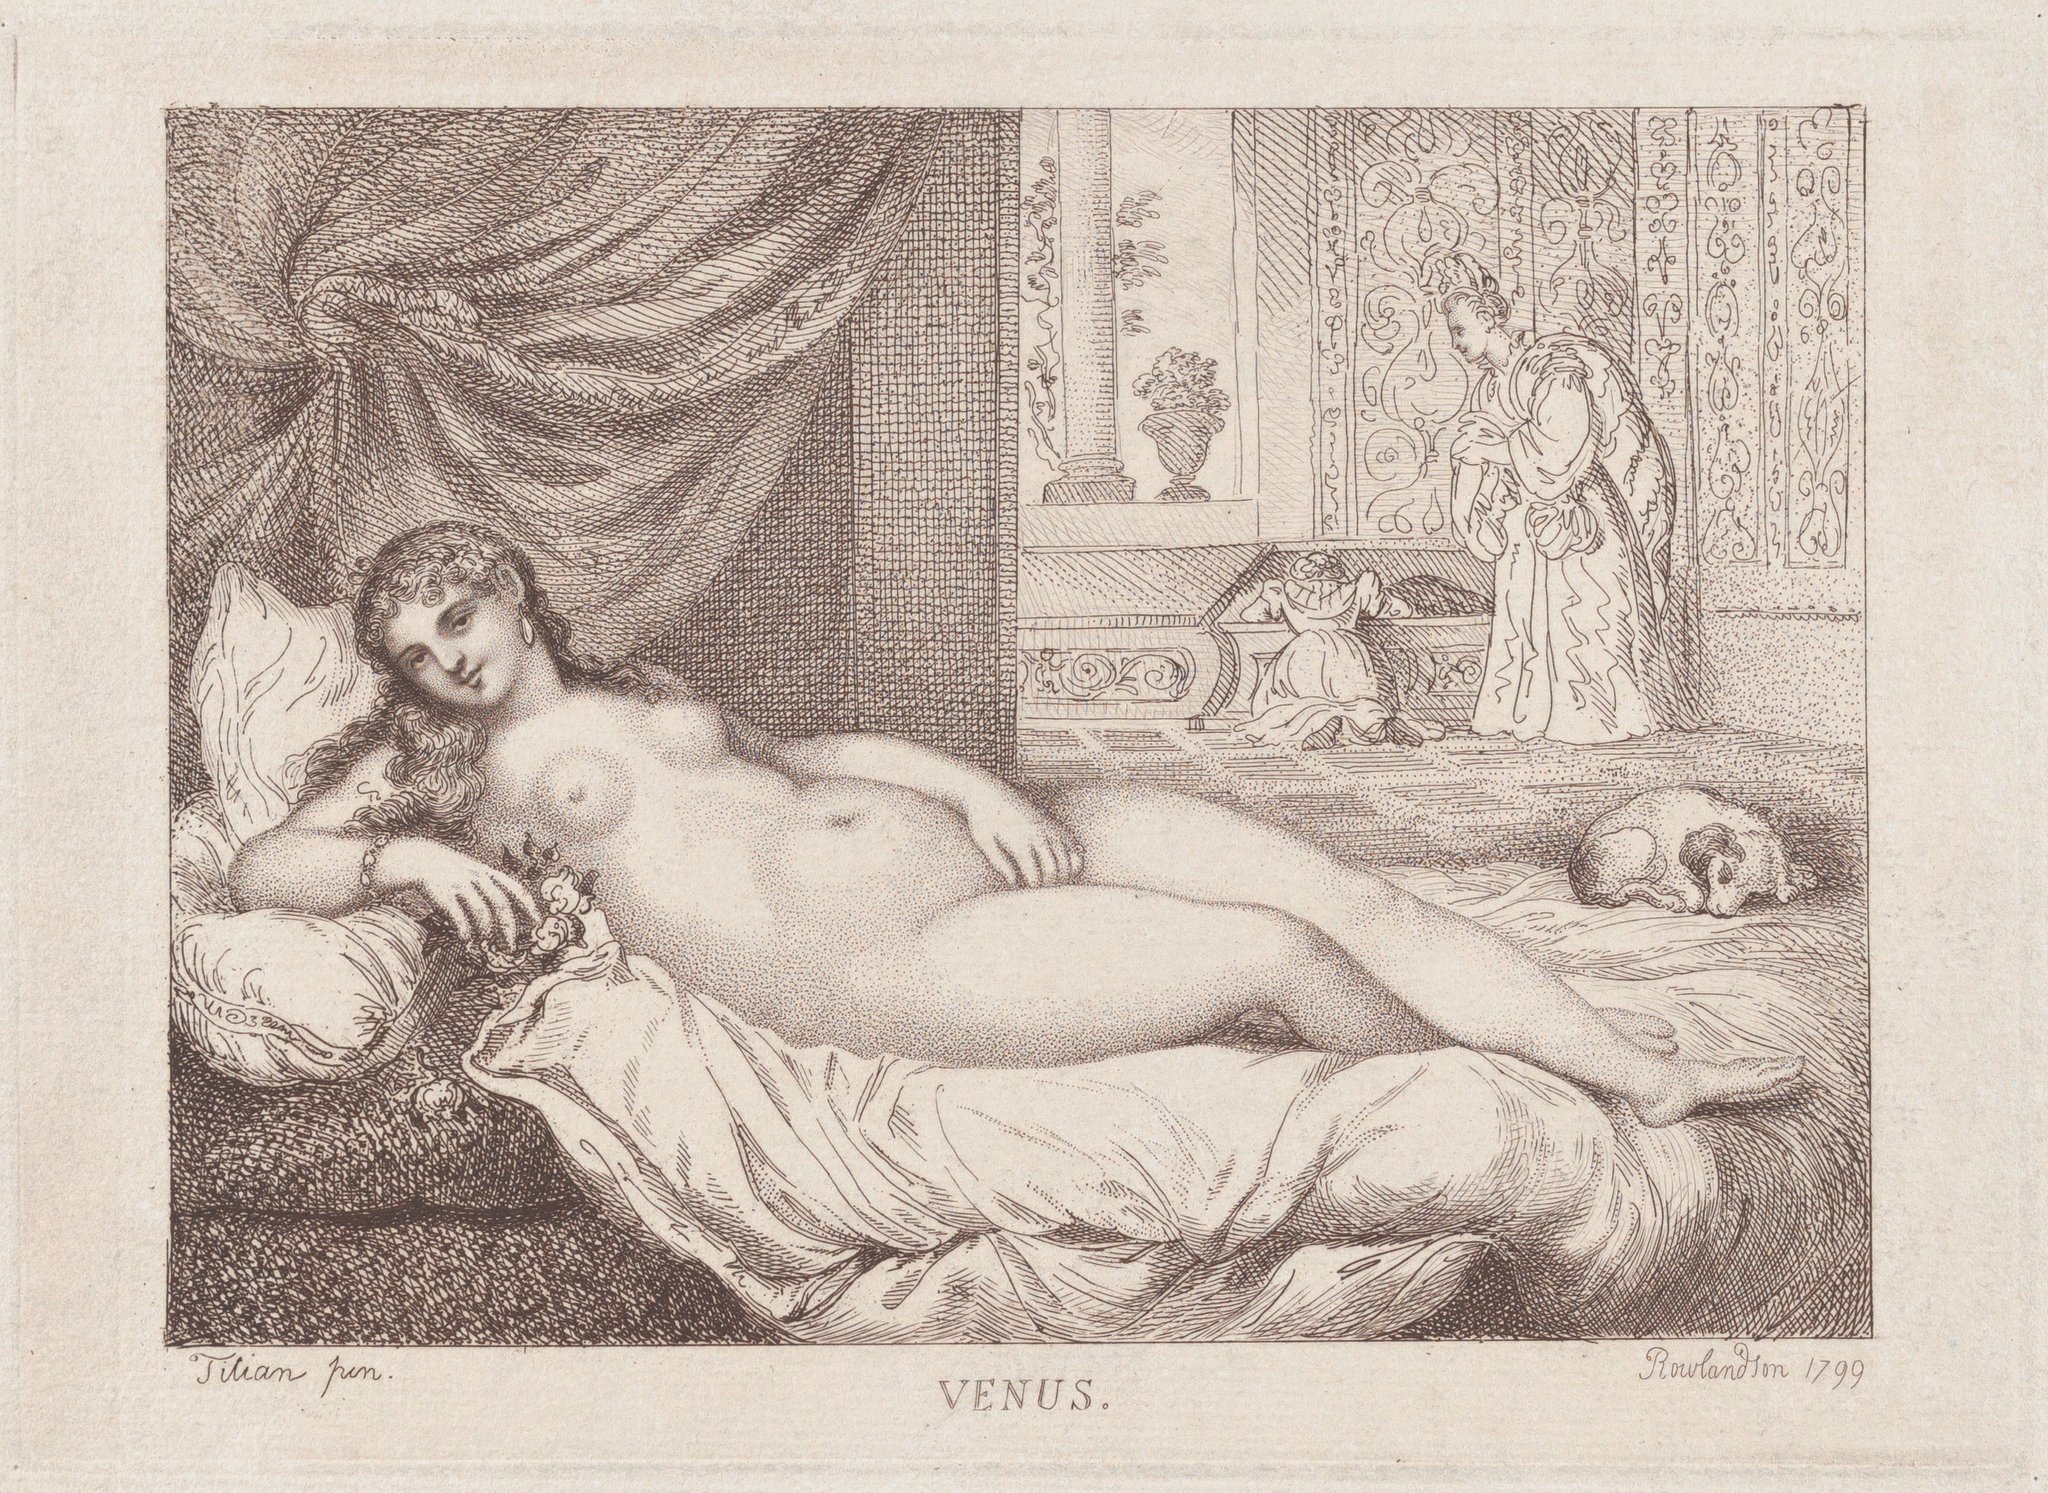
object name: print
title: Venus of Urbino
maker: thomas rowlandson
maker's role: artist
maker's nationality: british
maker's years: 1757-1827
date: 1799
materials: ink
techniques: etching, printing, stippling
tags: women,female nudes,venus,dogs